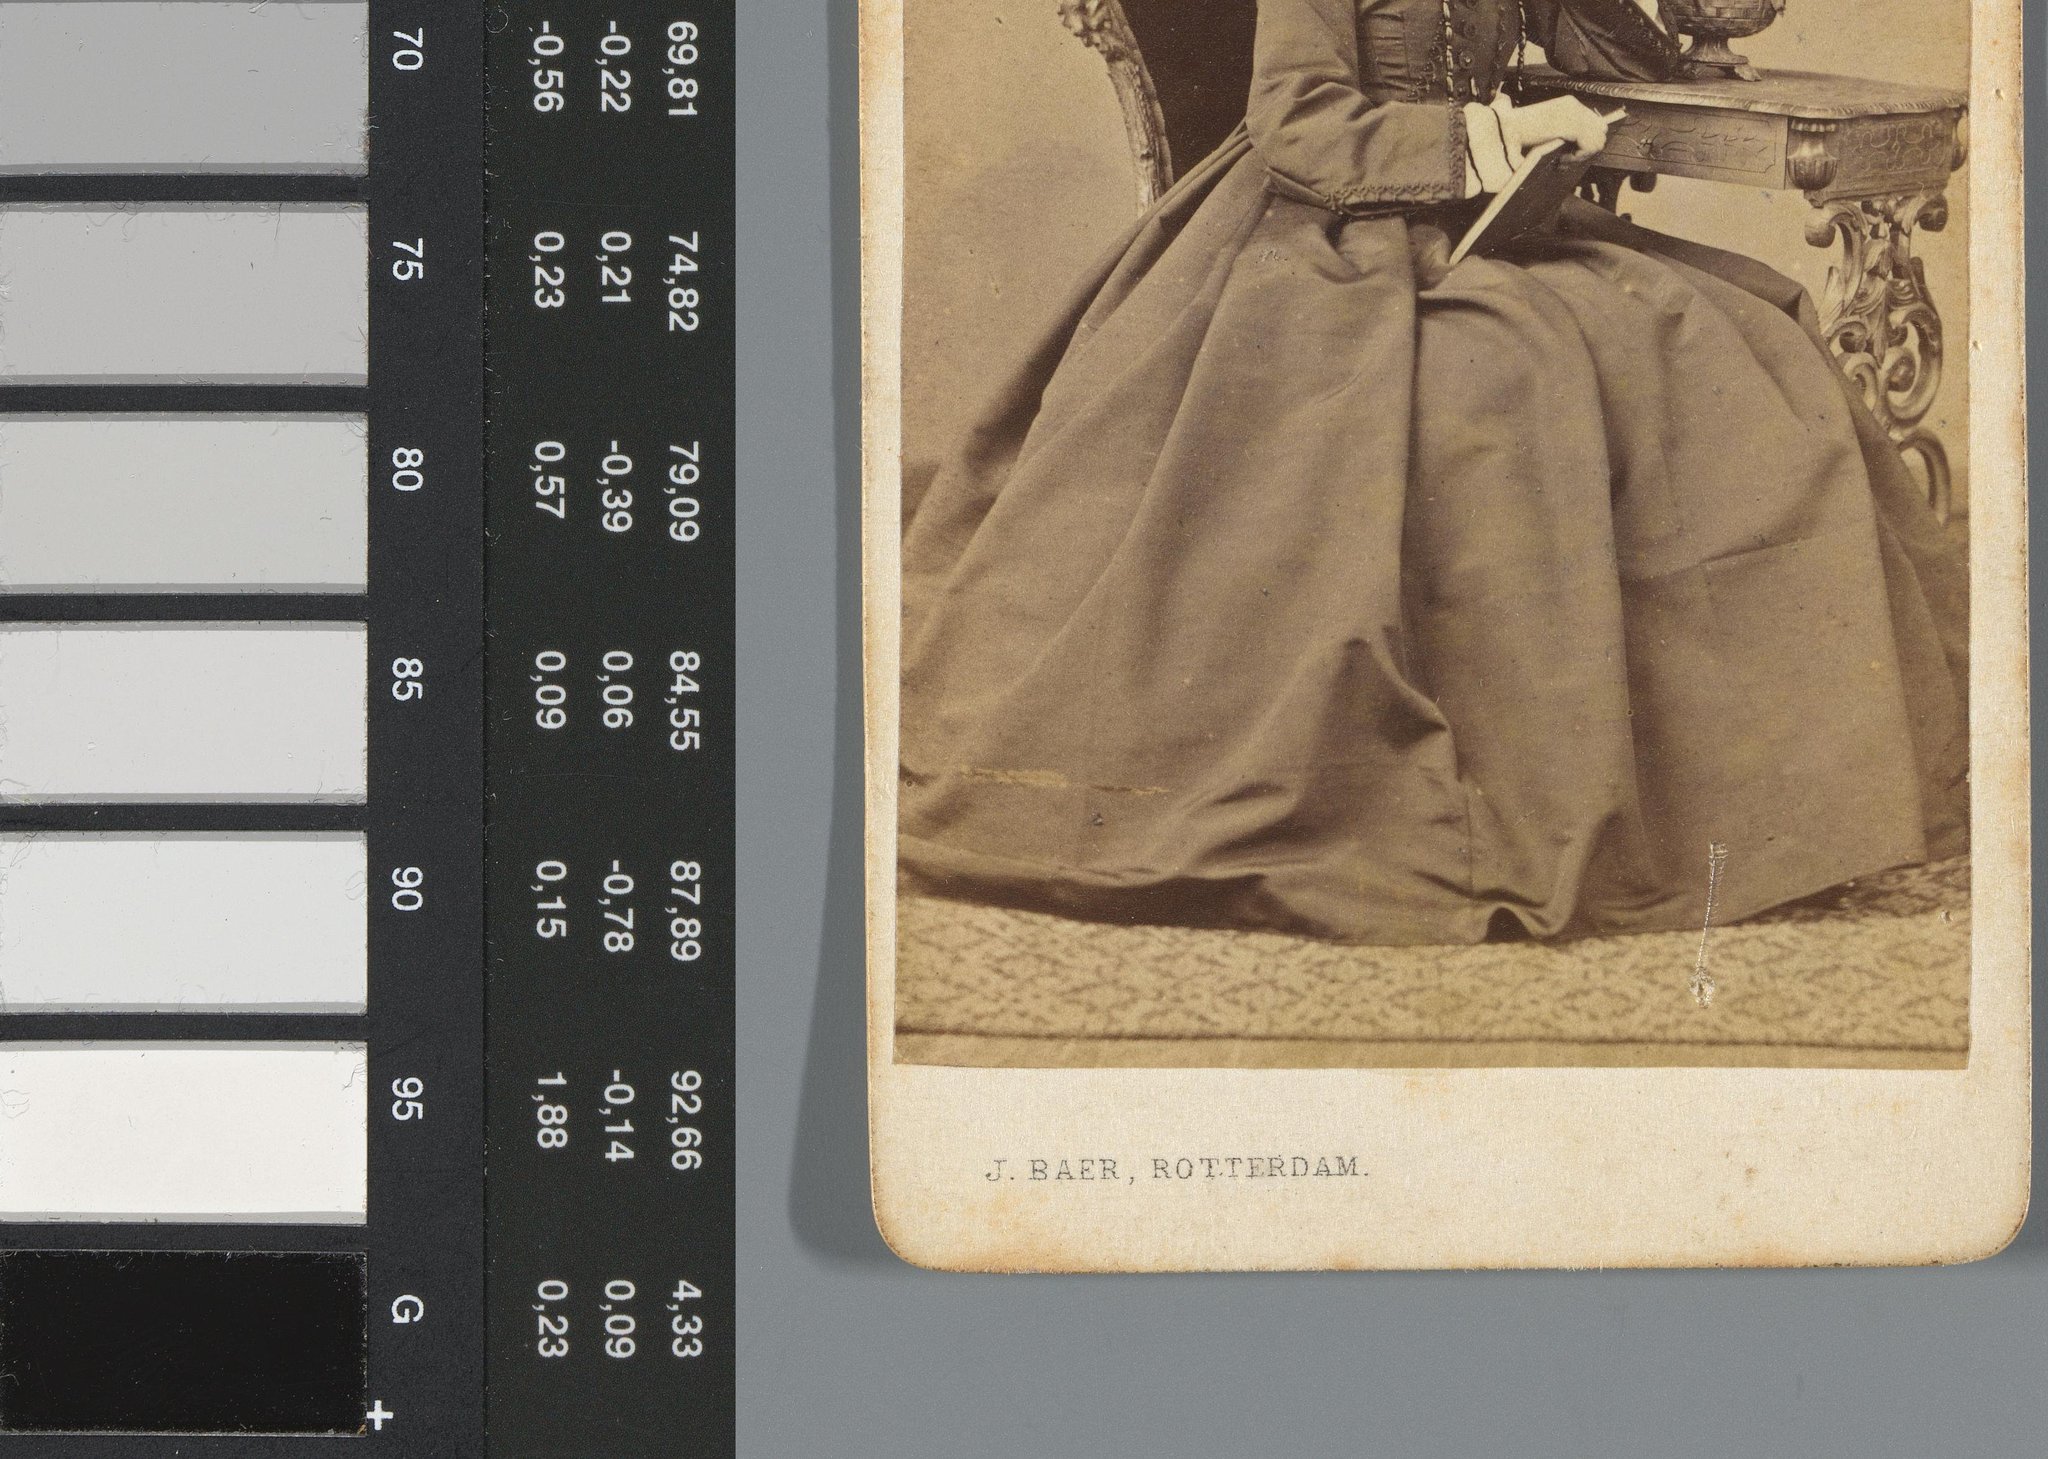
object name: photograph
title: Portret van Cornelia Theresia Carolina van den Berg (Cornelie)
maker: johannes baer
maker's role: fotograaf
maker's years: 1840-1912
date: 1855-1910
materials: cardboard, photographic support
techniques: albumen print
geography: rotterdam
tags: rotterdam, delft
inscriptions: name: ‘J. Baer , Rotterdam’, inscription: ‘tante Cornelie / v:d. Berg / 1837 - 1907’, name: ‘J. BAER / PHOTOGRAPHE / ROTTERDAM /’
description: Zittende vrouw aan tafel met een boek op haar schoot.